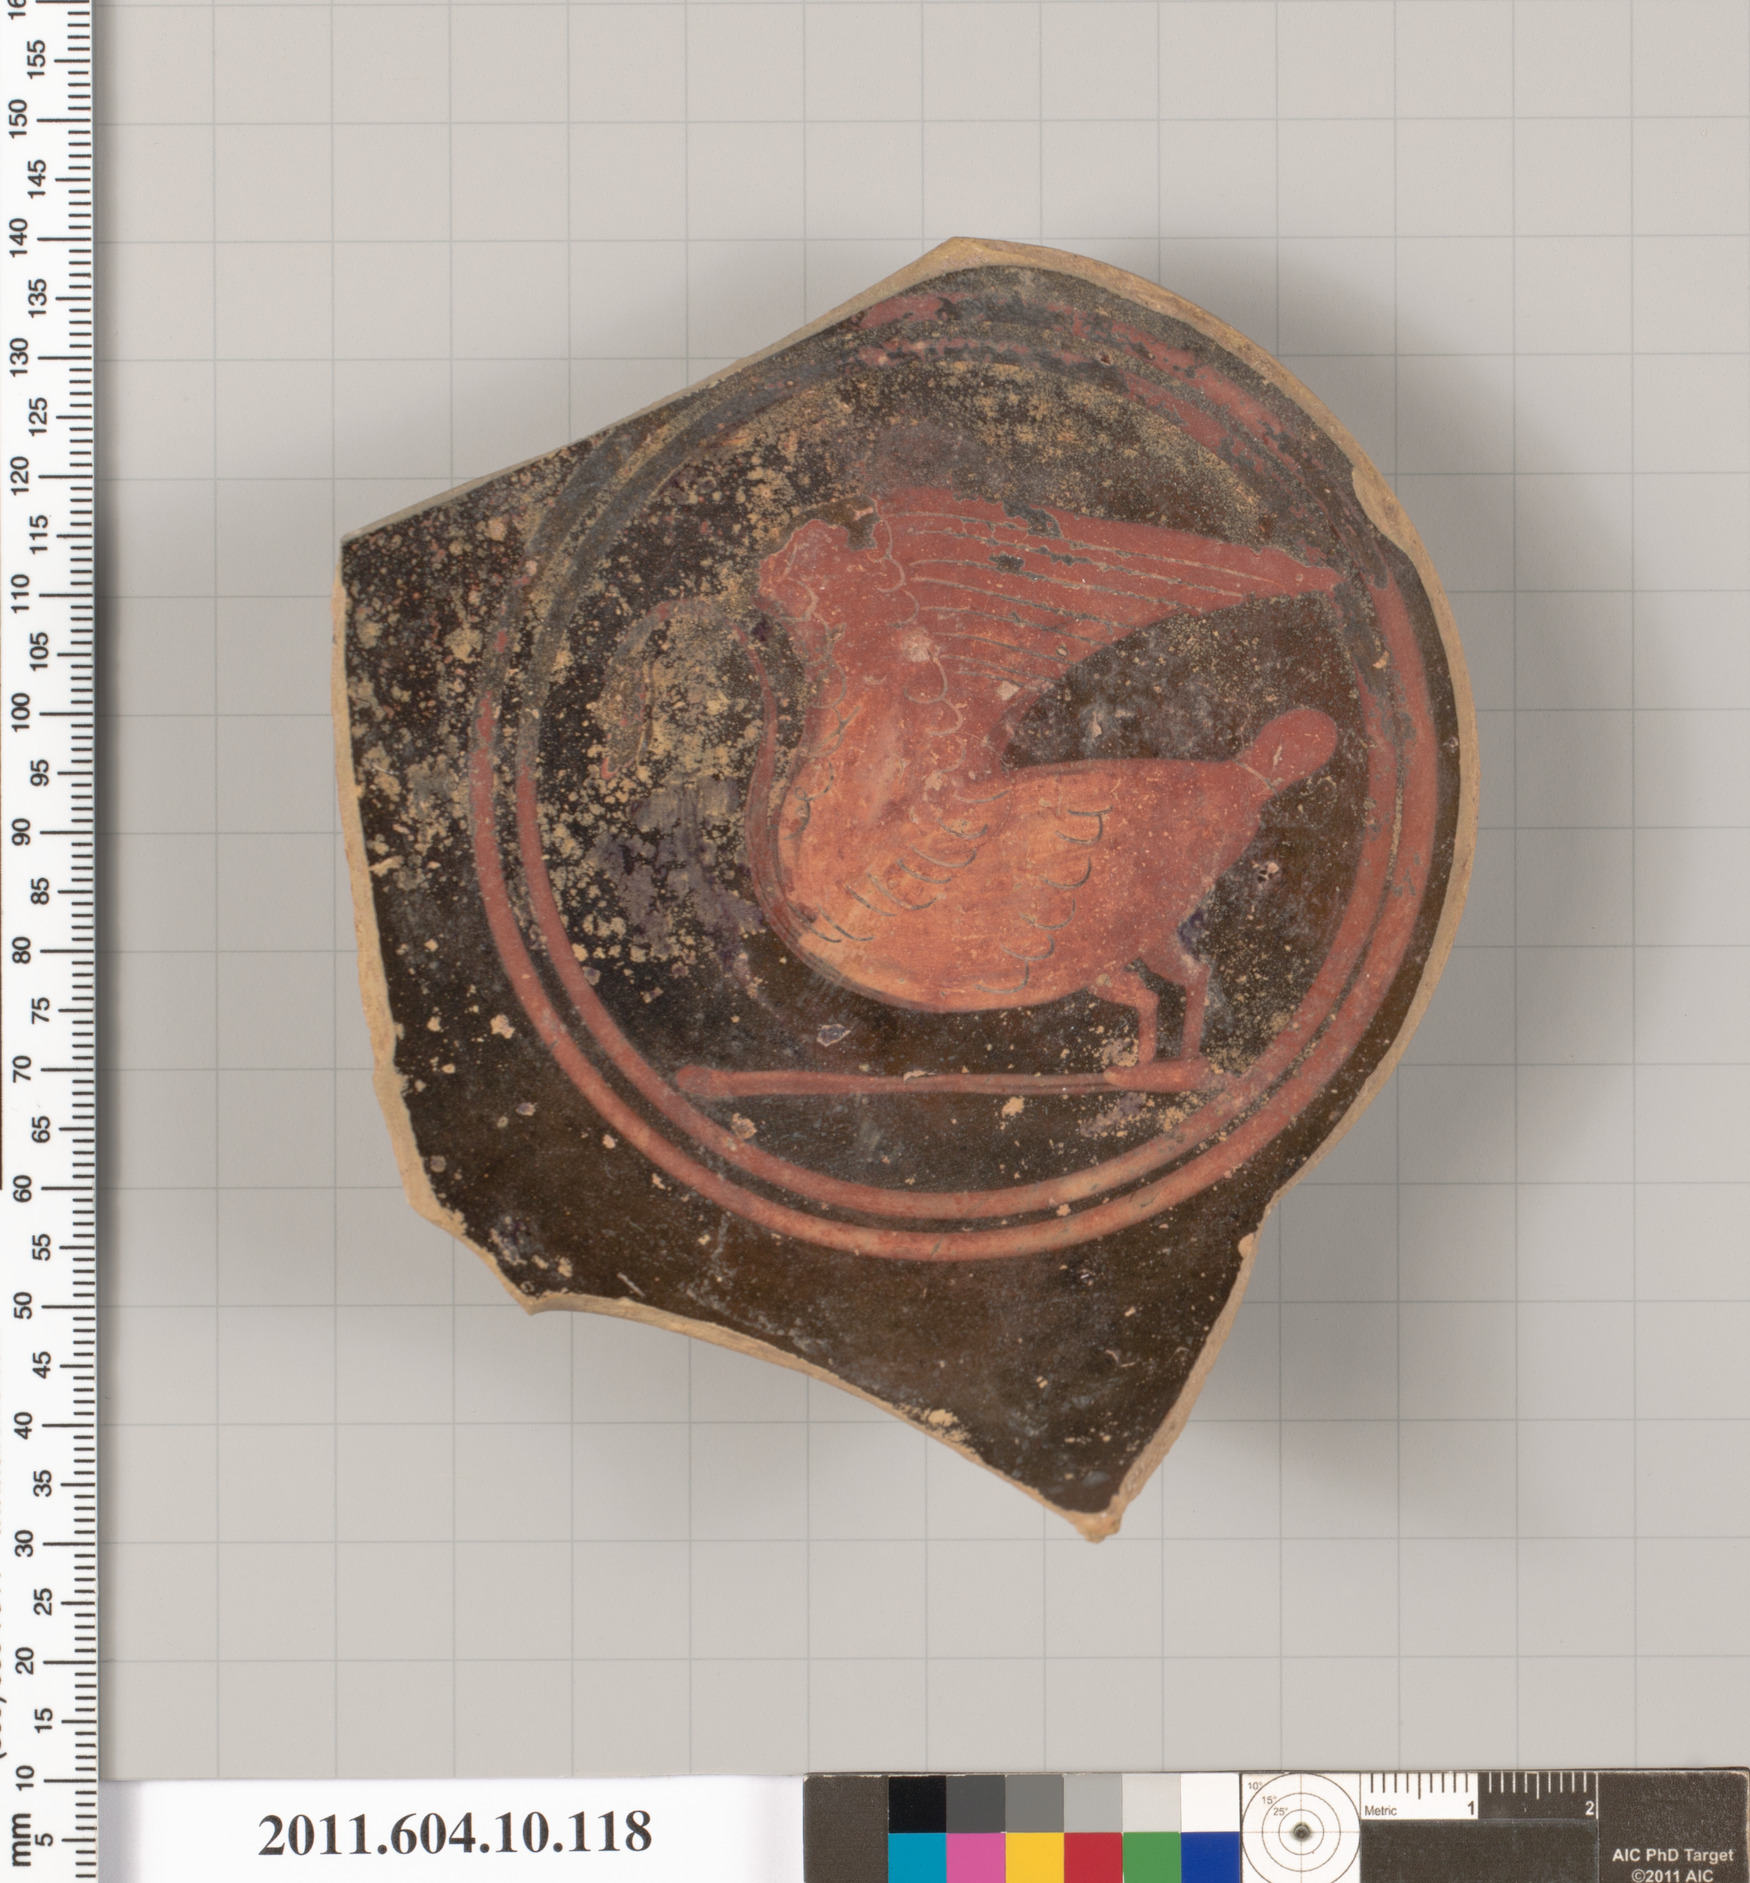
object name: kylix fragment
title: Terracotta fragment of a stemless kylix (drinking cup)?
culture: etruscan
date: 434-368 BCE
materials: terracotta